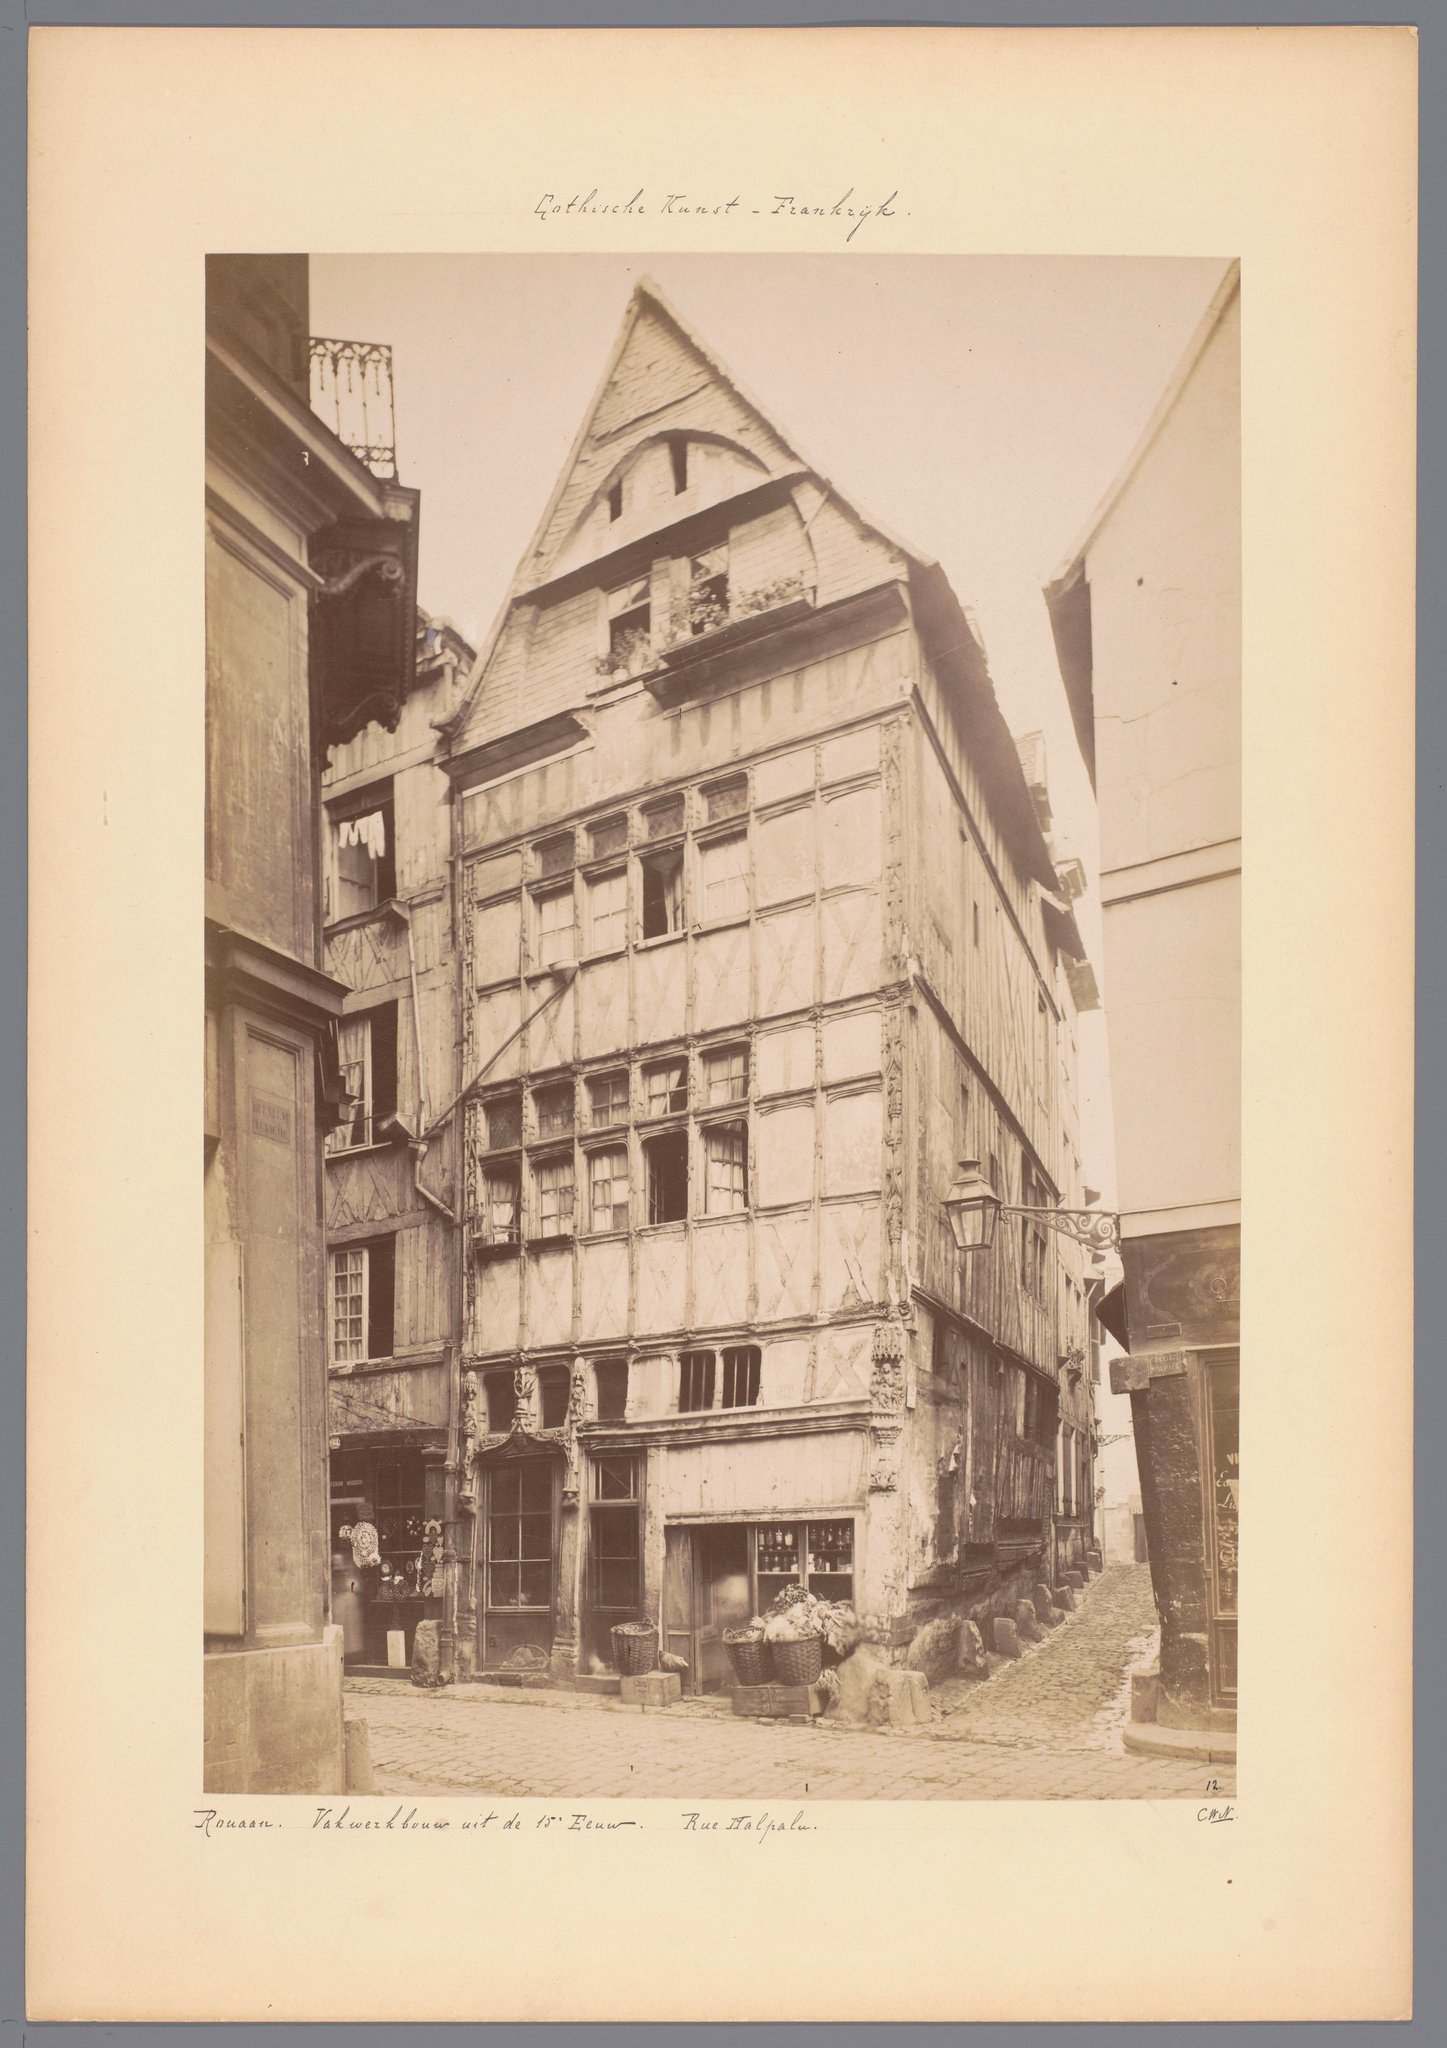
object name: photograph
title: Gevel van een vakwerkhuis aan de Rue Malpalm te Rouen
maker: séraphin-médéric mieusement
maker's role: fotograaf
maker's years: 1840-1905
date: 1875-1900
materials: cardboard, photographic support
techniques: albumen print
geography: rouen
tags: timber framing, housing, façade (of house or building), street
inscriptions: collector's mark: ‘KUNSTNIJVERHEIDSCHOOL QUELLINUS AMSTERDAM FRANS HALSSTRAAT 14.’, number: ‘12.’, inscription: ‘Gothische Kunst - Frankrijk. Rouaan. Vakwerkbouw uit de 15e Eeuw. Rue Malpalm.’, name: ‘MIEUSEMENT PHOTOGRAPHE’, inscription: ‘MONUMENTS HISTORIQUES’, collector's mark: ‘INSTITUUT VOOR KUNST- NIJVERHEIDSONDERWIJS GABRIËL METSUSTRAAT No. 16. AMSTERDAM’, inscription: ‘CWN.’